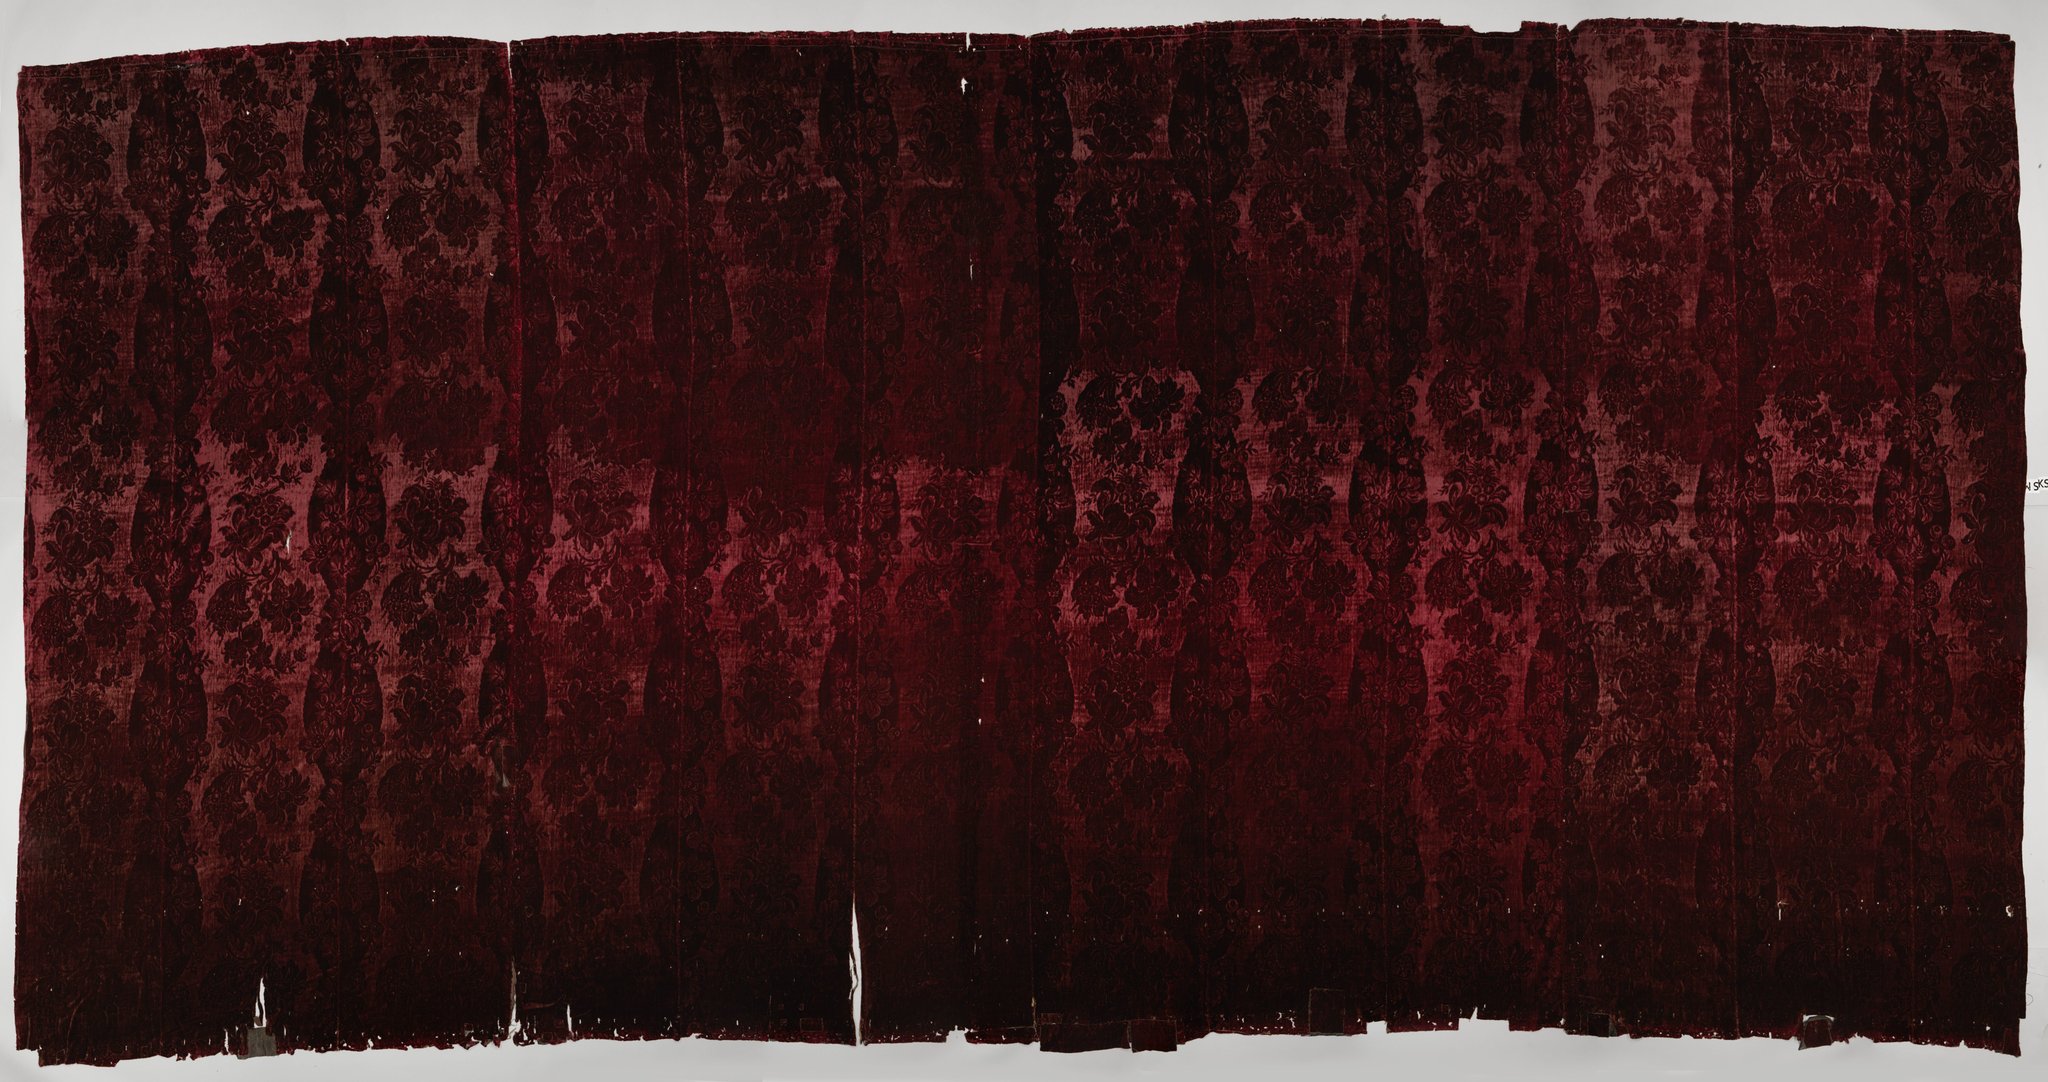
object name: hanging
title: Kamerbehangsel van wijnrood velours d'Utrecht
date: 1700-1750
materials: velvet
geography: northern netherlands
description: Kamerbehangsel van wijnrood velours d'Utrecht, d.i. een trijp met kettingpool van geitenhaar en inslag van blauw linnen en met ingedrukt patroon. De tekening vertoont langs de zelfkanten halve spitsovalen met gekartelde contour en onsymmetrische kleine bloemen en vruchten. In de middenbaan zijn grote bloembouquetten onsymmetrisch gerangschikt, bestaande uit korte afgebroken S-vormige stengel met neerbuigende samengestelde bloem en twee opgaande dito's en een tak met granaatappel, twee kleine rozetbloemen en twee vruchttrosjes. Het behangsel bestaat uit 6 muurvakken van 16 hele banen en 8 fragmentarische, wat een totaal van 1340 cm geeft.